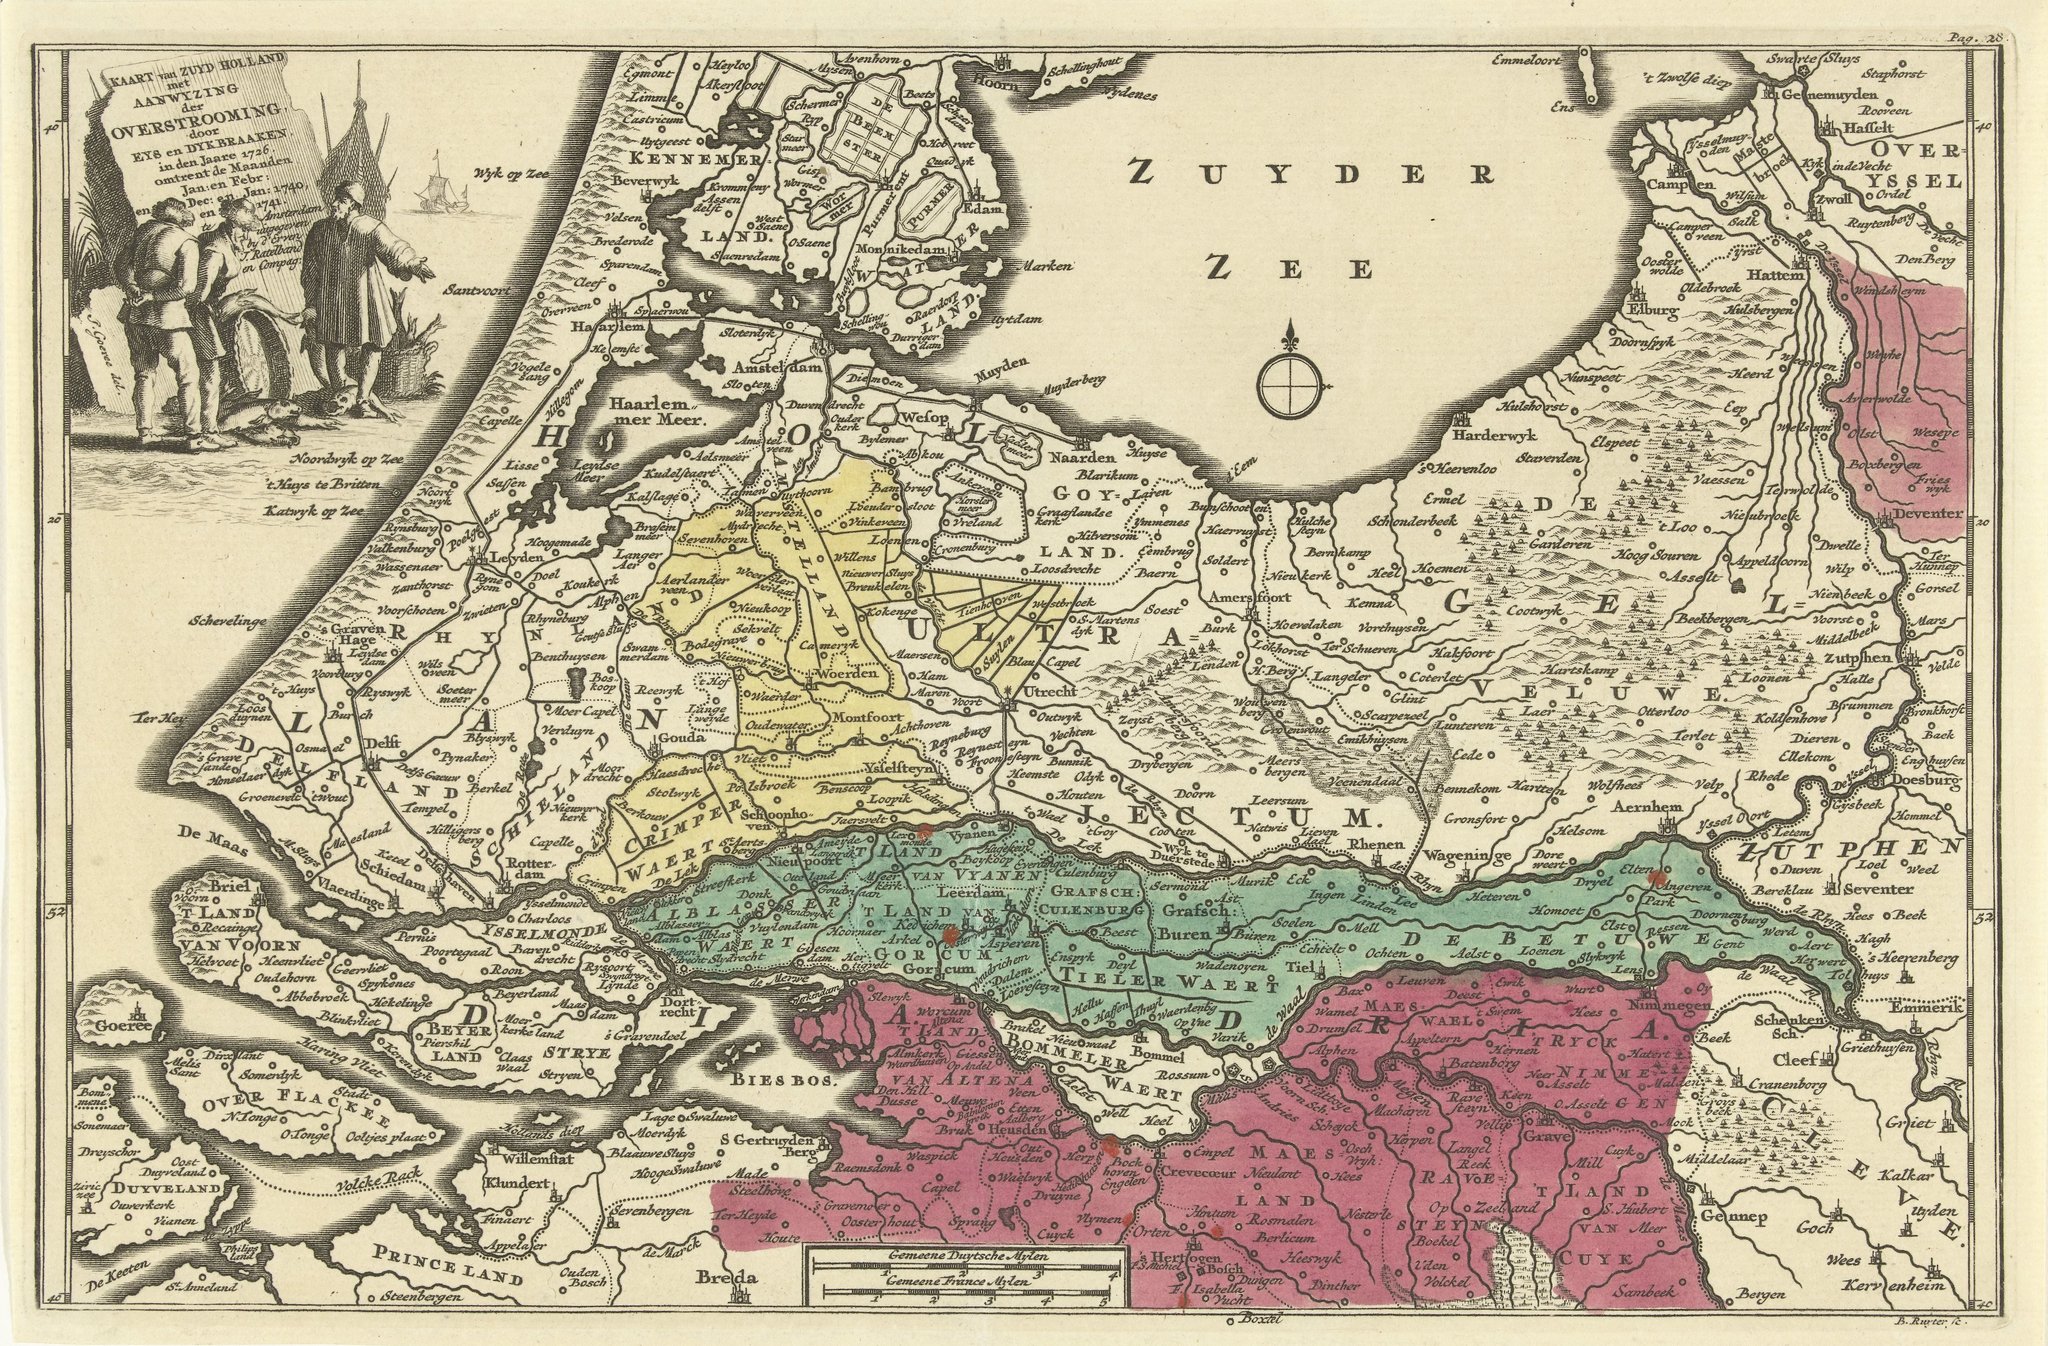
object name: text sheet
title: Korte Beschryvinge Van het Overlopen der Rivieren en Doorbreken der Dyken, te Hedikhuyzen, by de Stadt Heusden, en te Kedichem, by Leerdam, enz. tot ophelderinge en verklaringe van het nevenstaande Landkaartje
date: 1741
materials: paper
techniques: engraving, etching, hand coloring, letterpress printing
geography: amsterdam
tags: maps of separate countries or regions, flood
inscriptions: collector's mark: Lugt 2228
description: Kaart van Zuid-Holland waarop in verschillende kleuren de gebieden die getroffen zijn bij de overstromingen in begin 1726 en in december 1740 en januari 1741 zijn aangegeven, met de gedrukte verklaring die bij het kaartje hoort. Linksboven drie vissers bij cartouche. Rechtsboven gemerkt: Pag. 28. Midden onder twee schaalstokken: 4 Gemene Duytsche Mylen / 5 Gemene France Mylen.